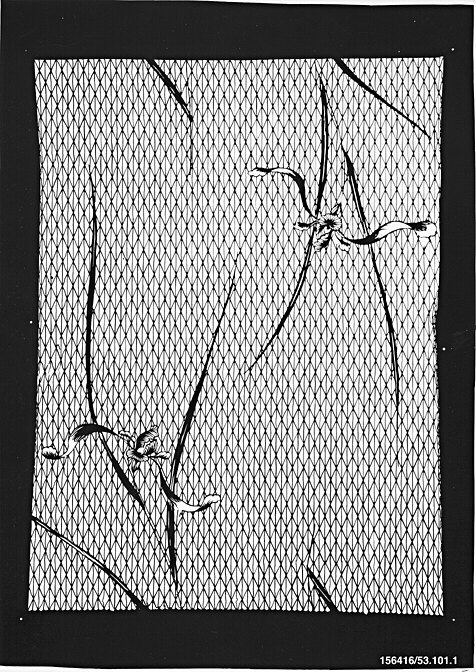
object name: stencil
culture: japanese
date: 1615-1868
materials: paper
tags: flowers